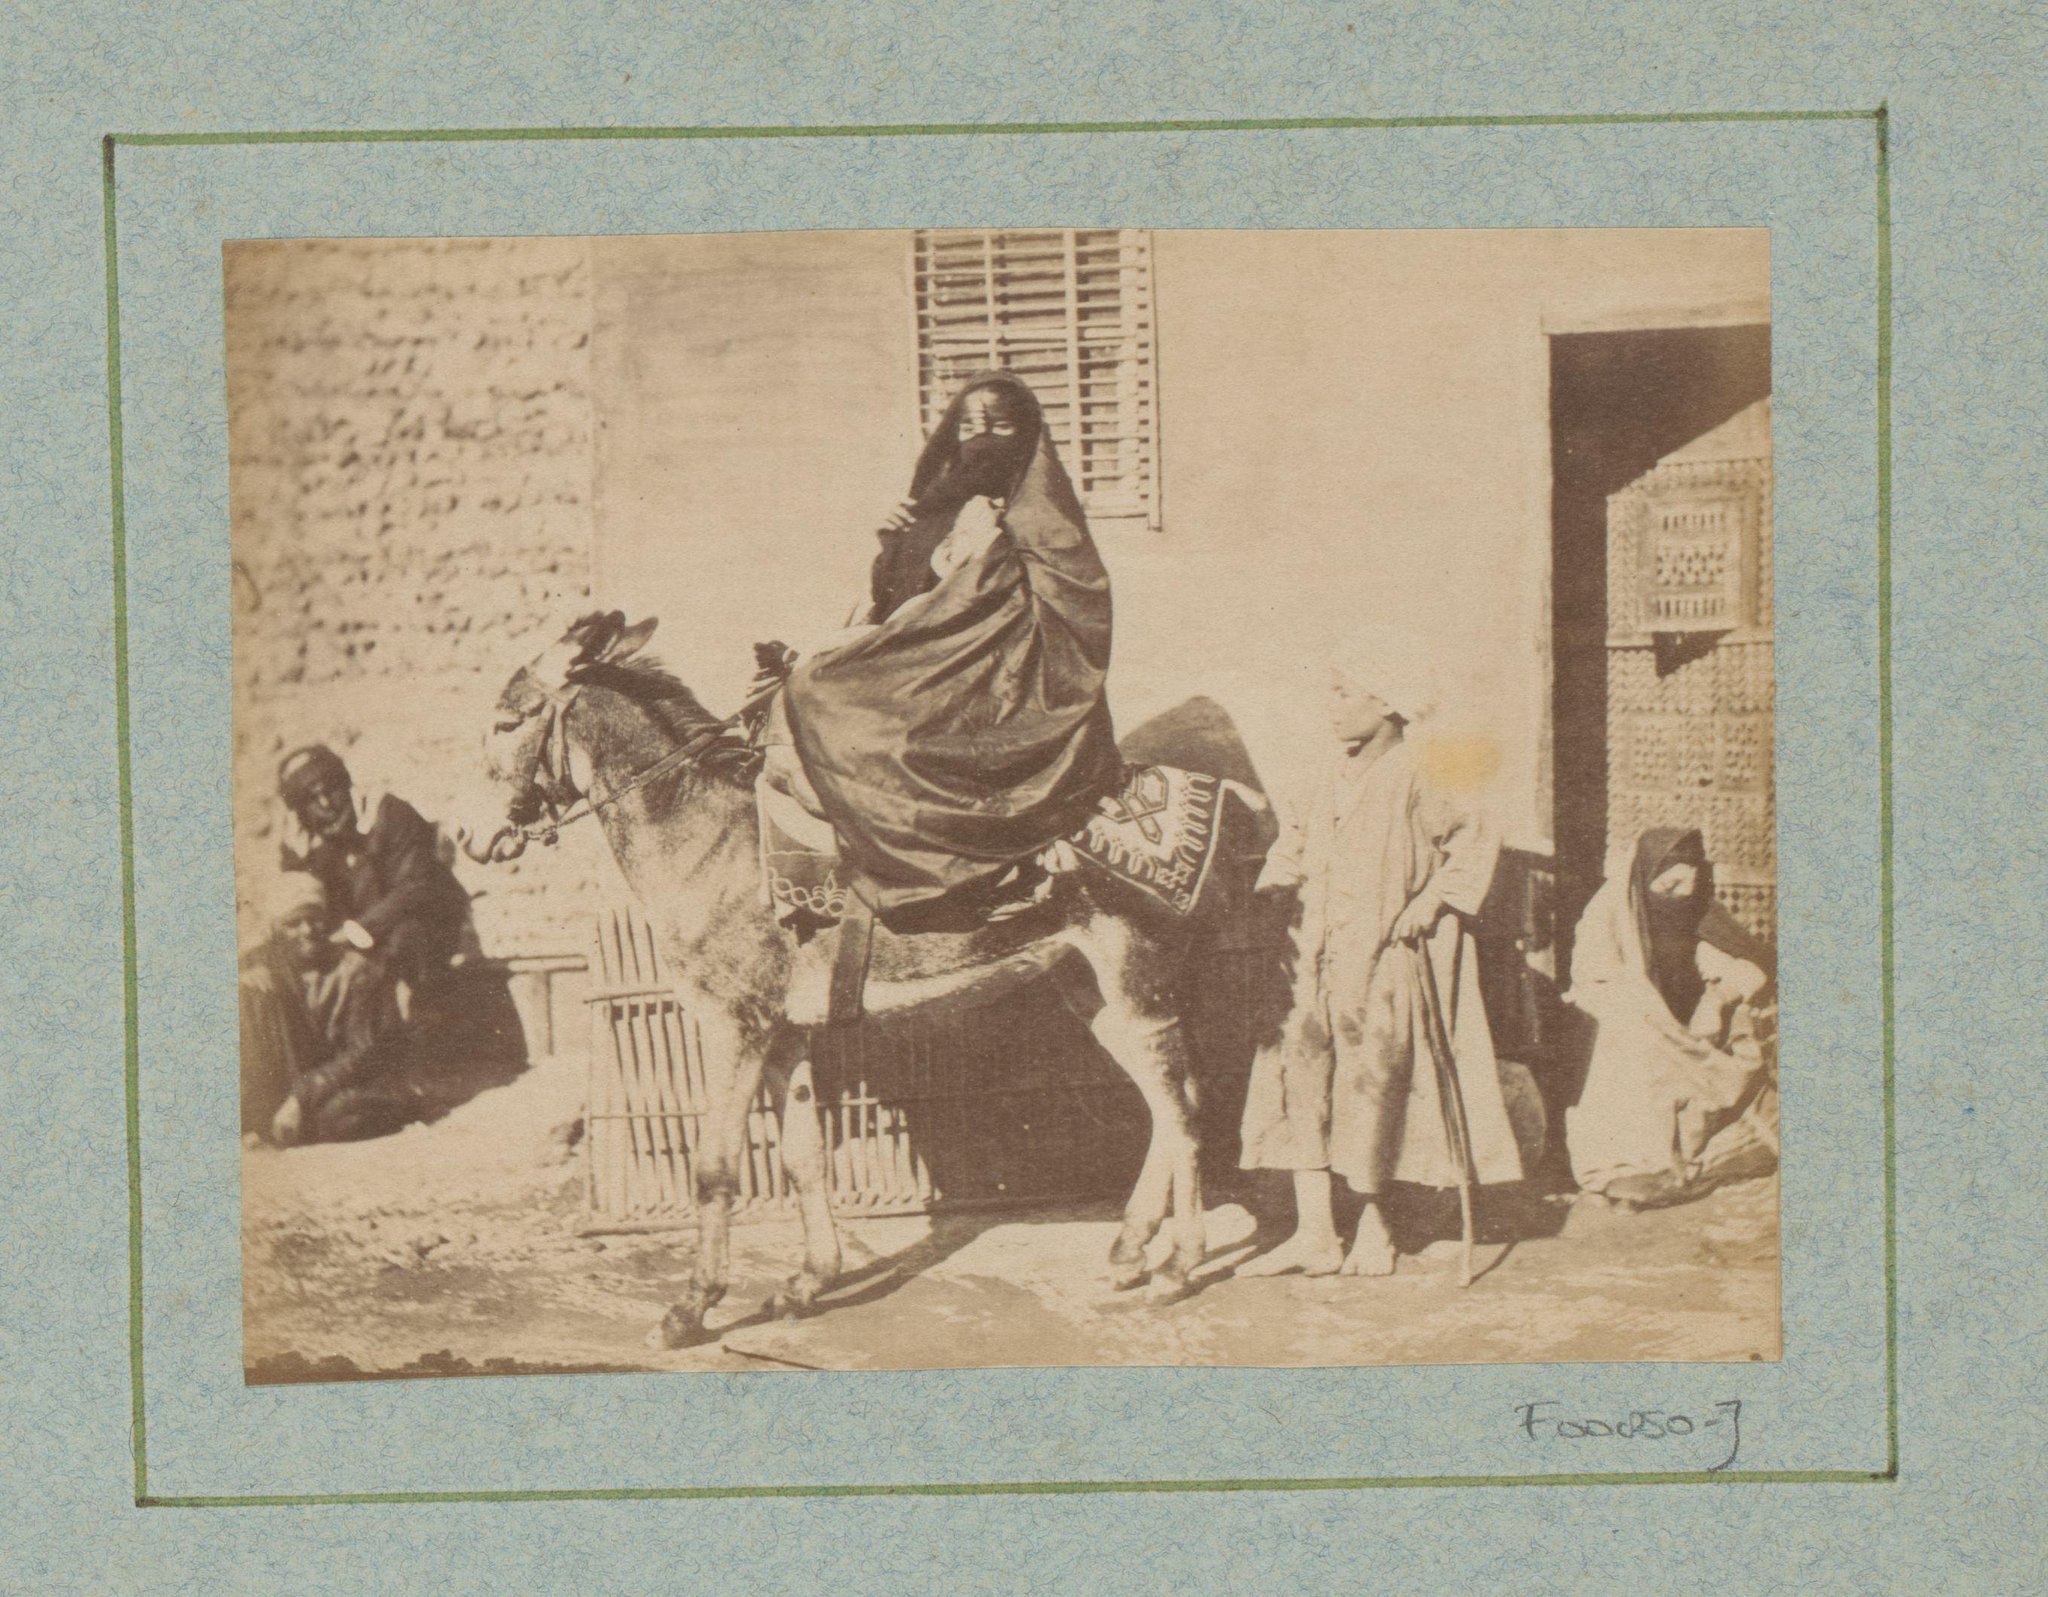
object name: album leaf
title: Gesluierde Egyptische vrouw op een ezel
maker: Anonymous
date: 1850-1890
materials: cardboard, photographic support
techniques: albumen print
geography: egypt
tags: adult woman, ass, donkey, clothes covering the entire body